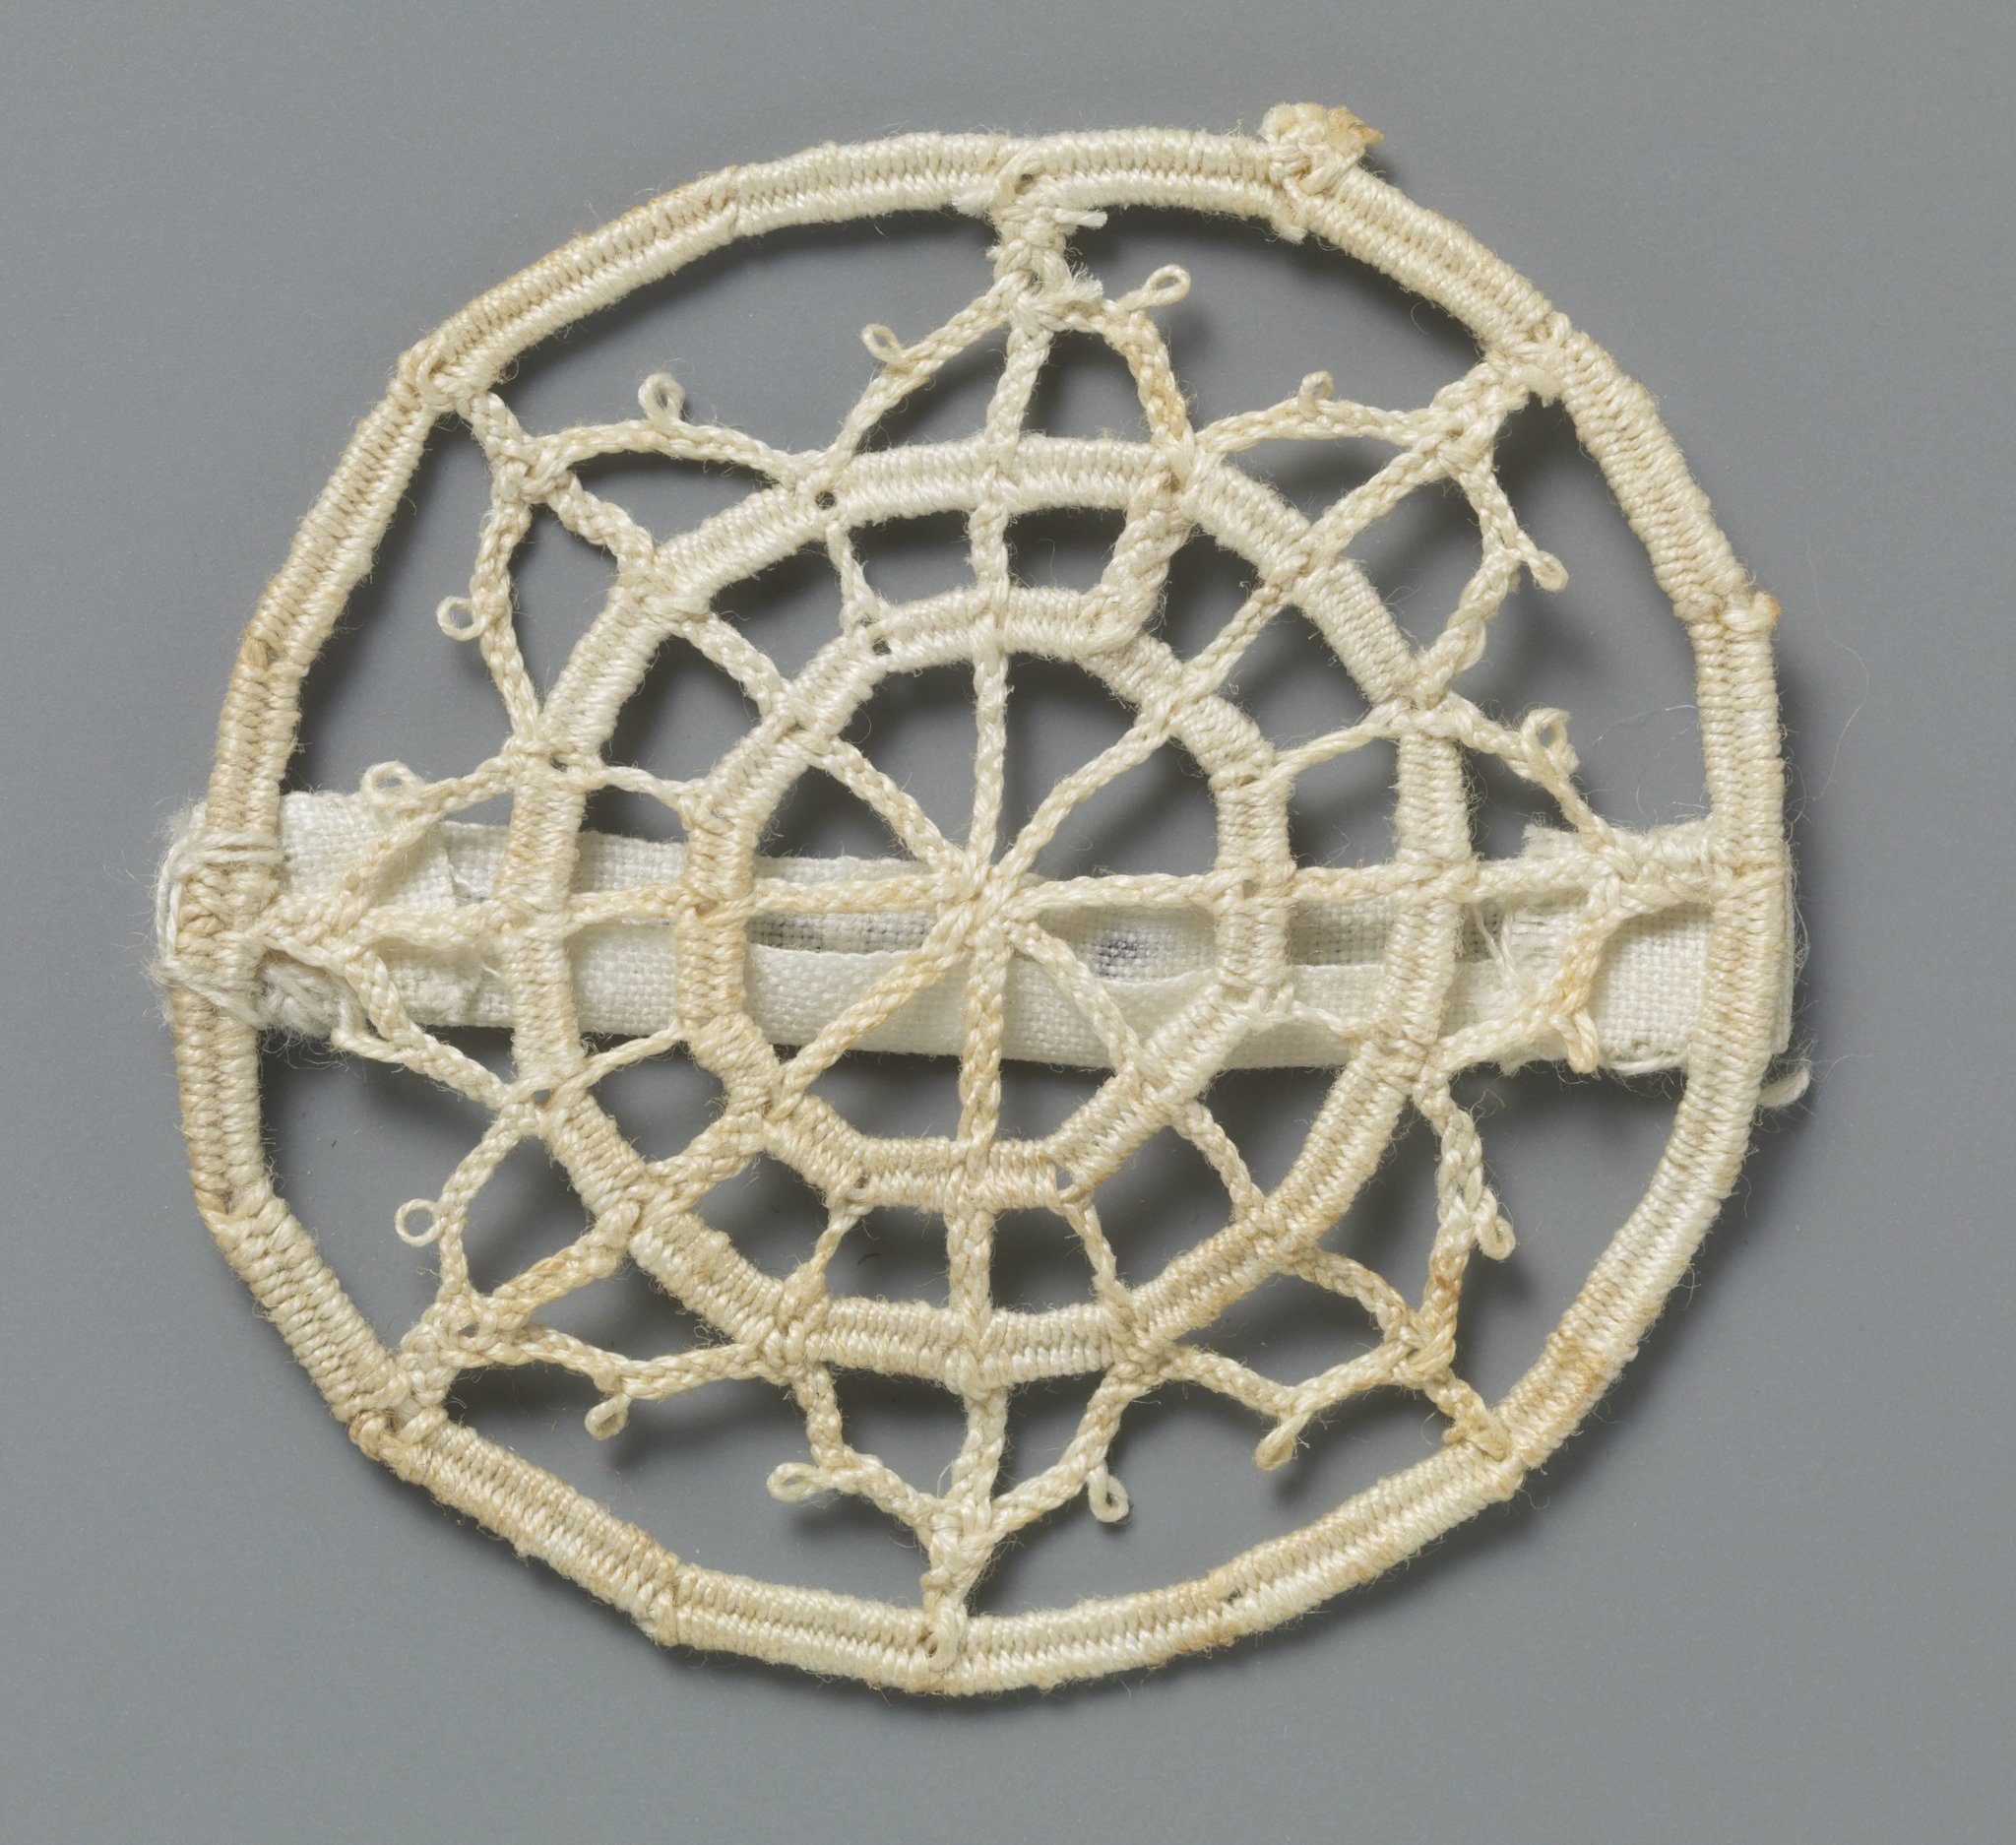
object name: incrustatie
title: Cirkelvormige incrustatie van kloskant met rozet en acht spaken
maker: Anonymous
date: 1900-1924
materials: linen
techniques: lace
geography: volvic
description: Cirkelvormig opengewerkt kleedje, mogelijk een incrustatie, van naturelkleurige kloskant. Het patroon bestaat uit een rozet die is opgebouwd uit drie concentrische cirkels, met acht spaken. Tussen de twee buitenste cirkels is een aaneenschakeling van boogjes gemaakt, als bloemblaadjes van de rozet, waarbij elk boogje door een spaak wordt doorsneden. De cirkels zijn gemaakt in vormslag met twee ribben, de spaken en boogjes met vlechtjes. De vlechtjes waarmee de boogjes zijn gemaakt zijn voorzien van picots.